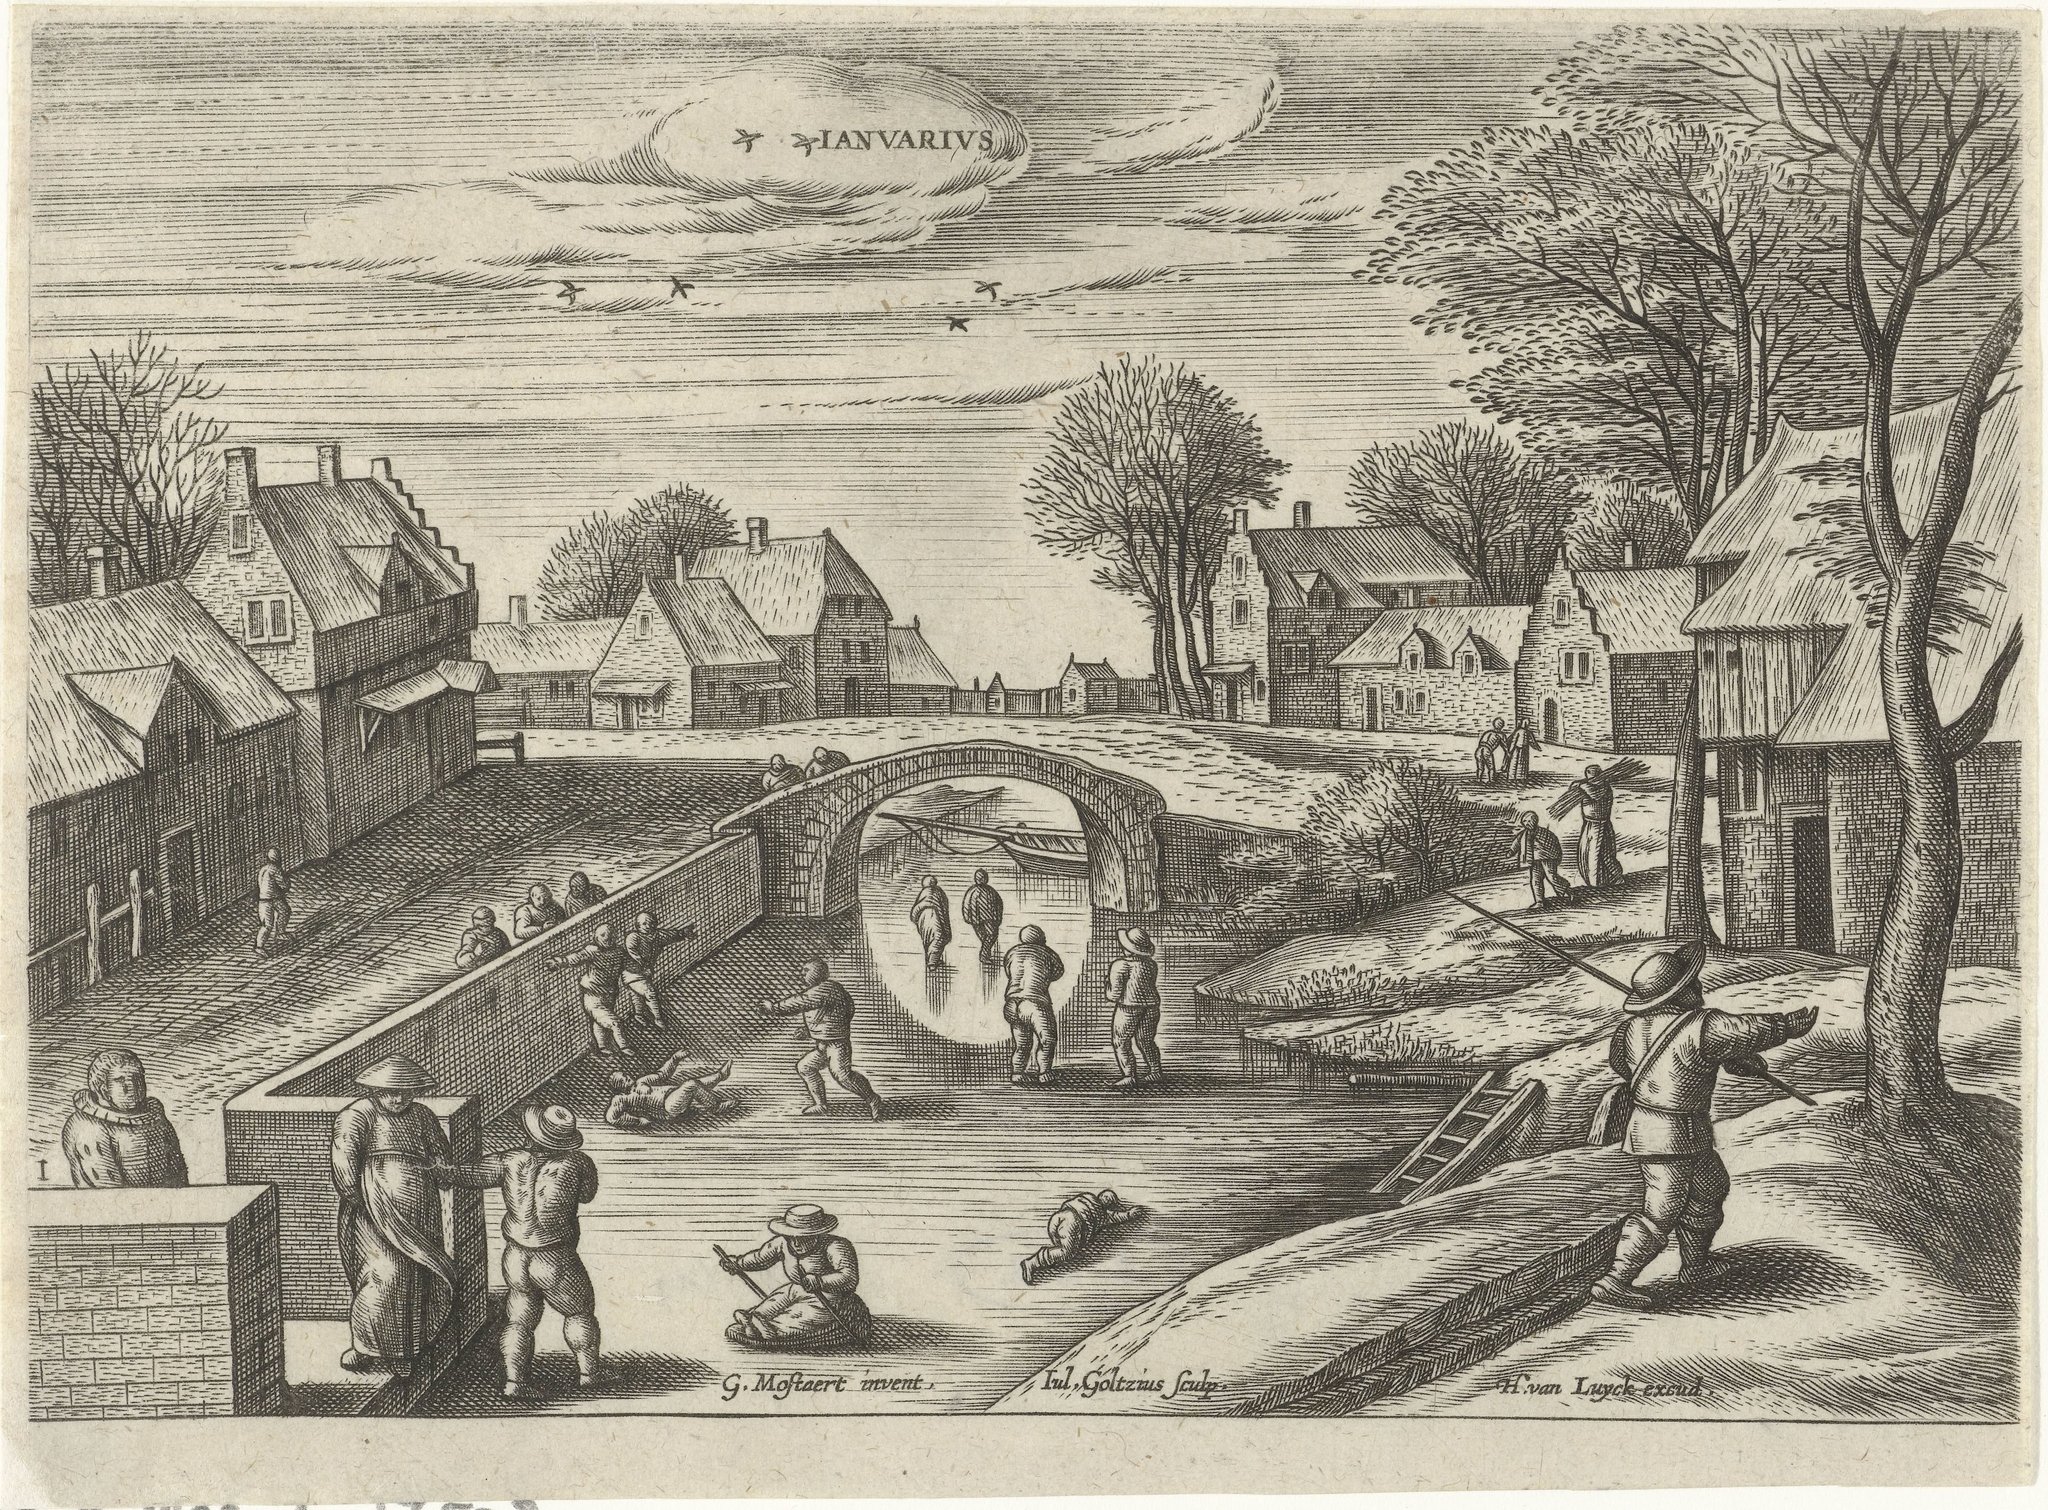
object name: print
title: Januari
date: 1560-1595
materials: paper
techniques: engraving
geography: antwerp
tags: january and its 'labours', skates (winter sports)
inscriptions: collector's mark: Lugt 2228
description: Winterlandschap met wintertaferelen. Januari is de ijsmaand. Er wordt geschaatst op een kanaal. Mensen zoeken naar sprokkelhout. Deel van een serie van de twaalf maanden, waarbij elke maand wordt afgebeeld met de voor haar typerende menselijke activiteiten en haar klimatologische kenmerken.